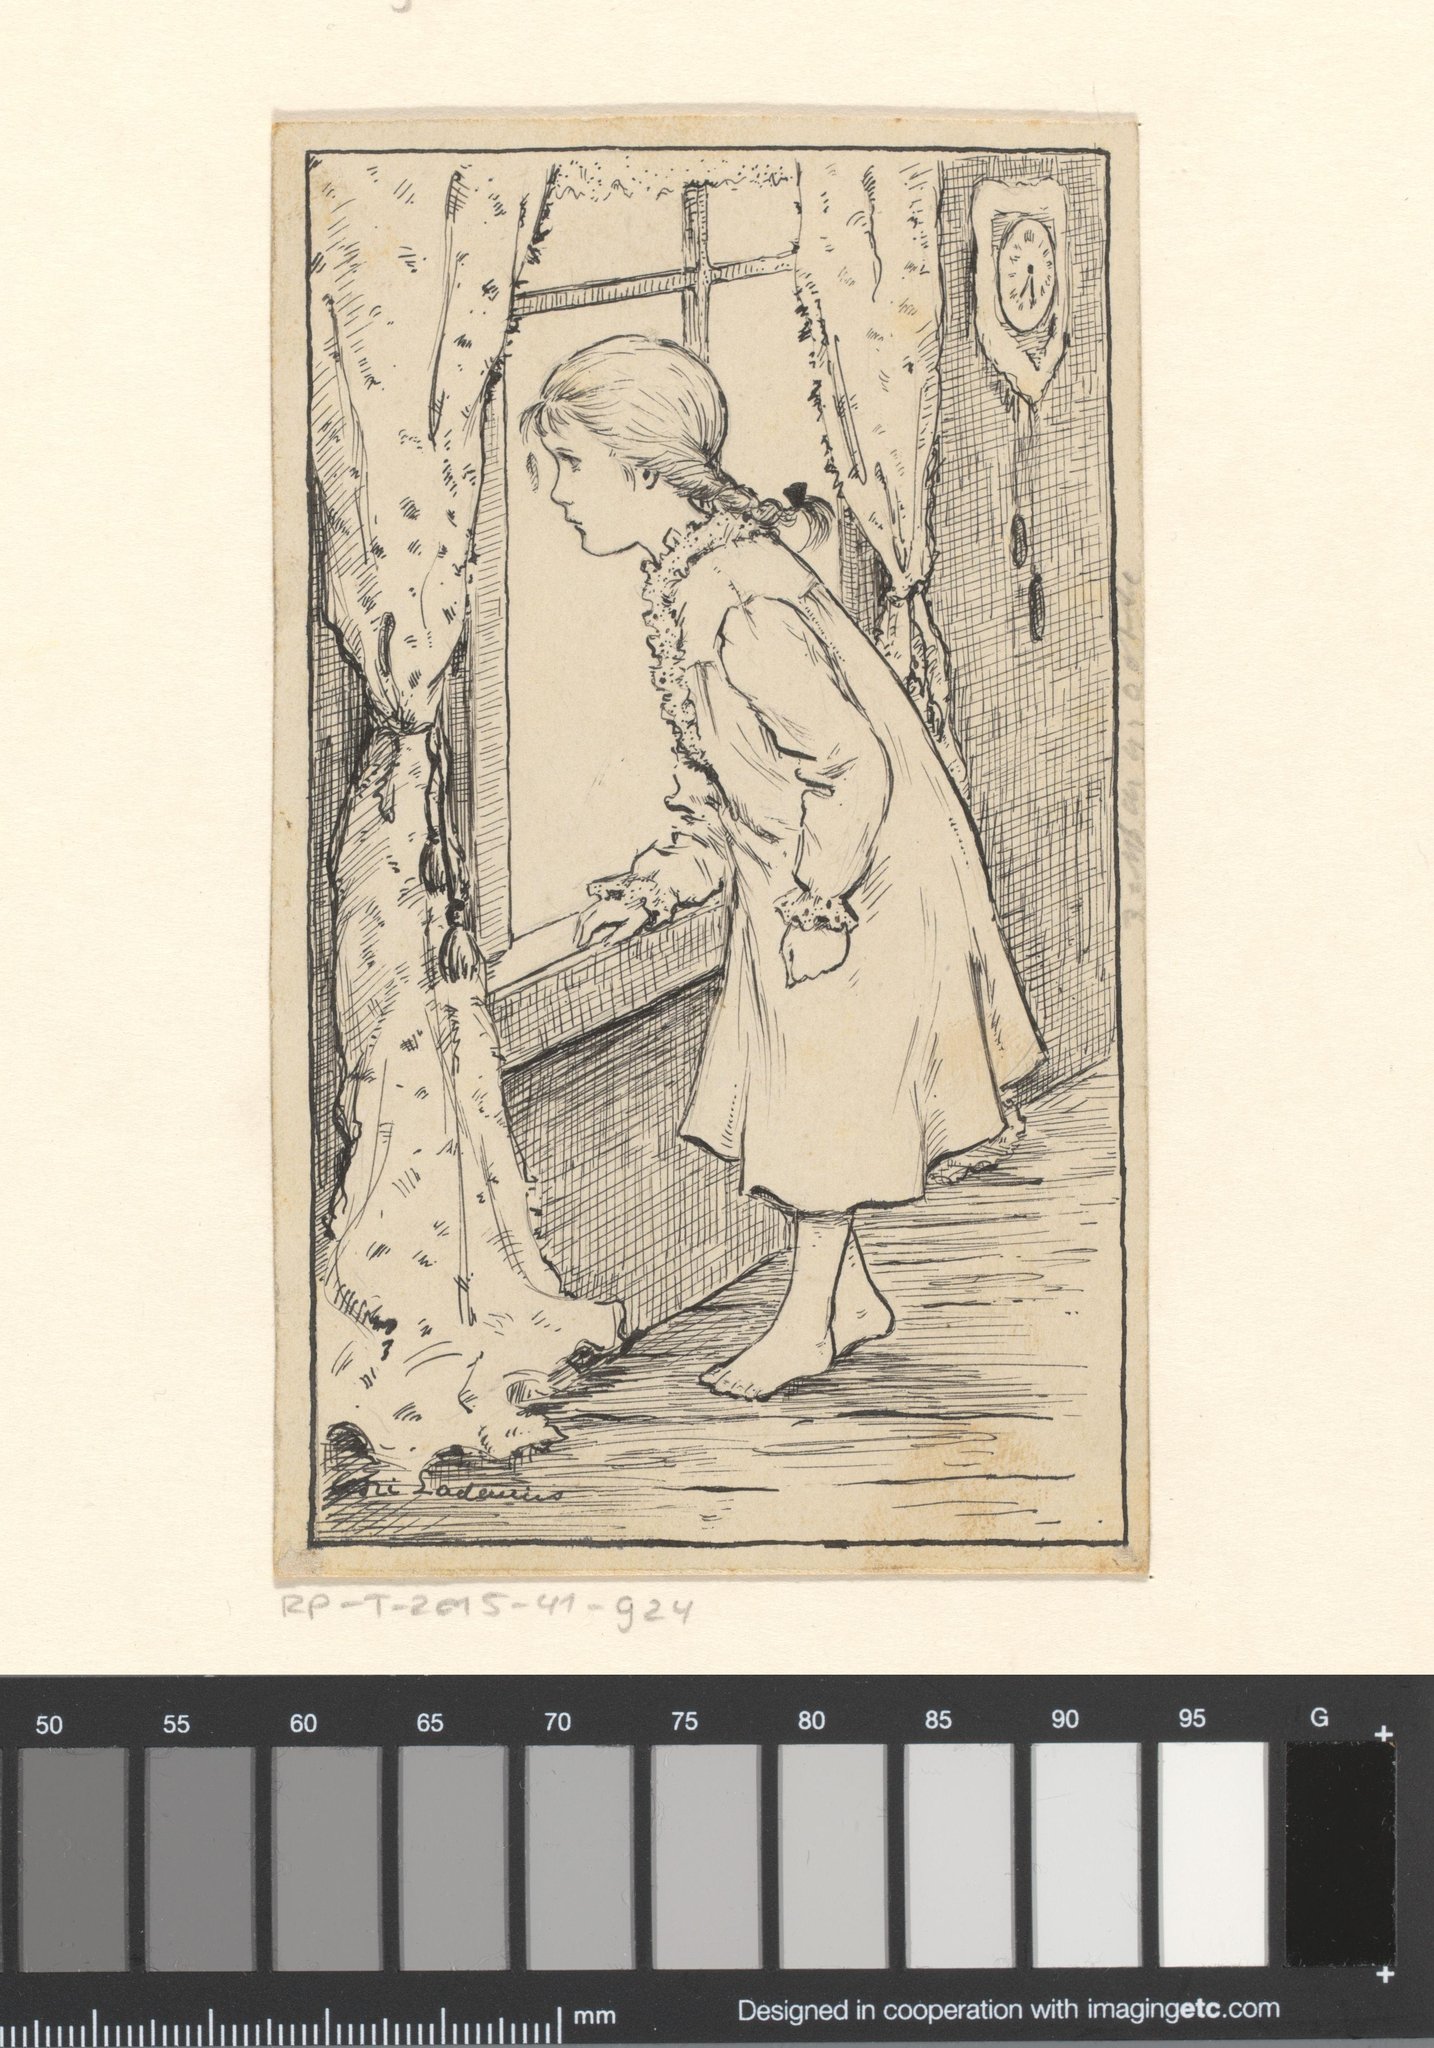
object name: drawing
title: Meisje in nachtjapon bij een raam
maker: adri ladenius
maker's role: draughtsman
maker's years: 1883-1953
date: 1893-1953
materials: ink, paper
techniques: pen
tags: window, girl (child between toddler and youth), nightwear: night-gown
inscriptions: collector's mark: Lugt 2228, annotation: ‘I/ O, o, wat is 't koud!/ Ze kan niet eens door/ de ruit zien - de heele/ thermometer is niet/ te zien. Krabben, krab-/ ben op de ruit! Nu/ heeft ze een streepje,/ waar je door zien kan./ Laat es kijken!/ 12 graden Celsius!’, signature: ‘Adri Ladenius’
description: Een meisje in een nachtjapon met een vlecht in het haar kijkt uit een raam. Naast het raam hangt een klok.